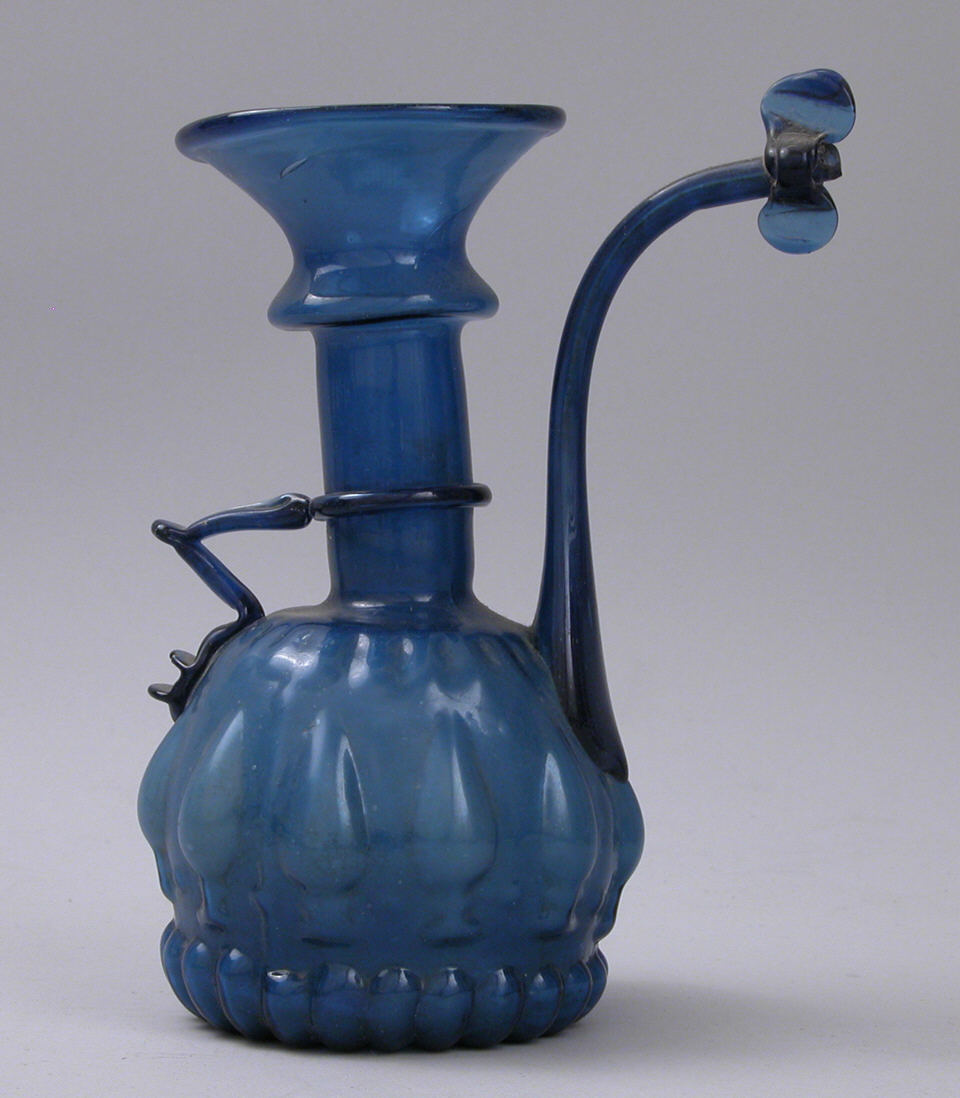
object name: ewer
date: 1701-1900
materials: glass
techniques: glassblowing, tooling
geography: iran